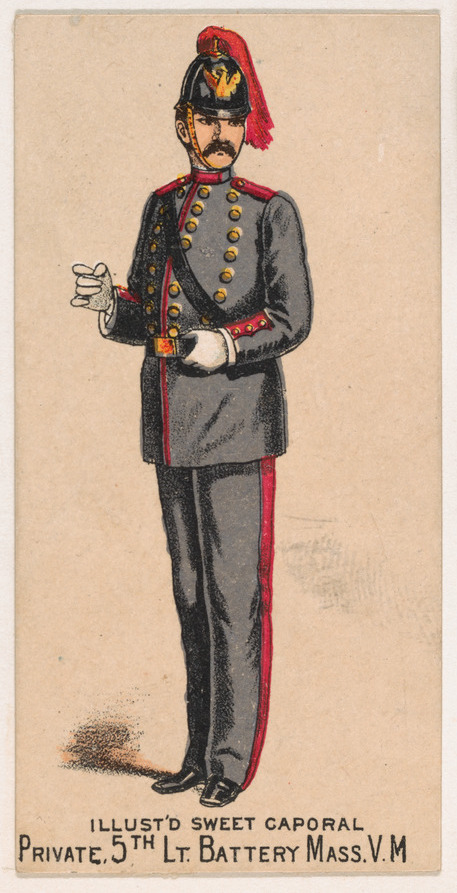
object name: print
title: Private, 5th Light Battery, Massachusetts, V.M., from the Military Series (N224) issued by Kinney Tobacco Company to promote Sweet Caporal Cigarettes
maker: kinney brothers tobacco company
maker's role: publisher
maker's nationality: american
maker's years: 1869-2011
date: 1888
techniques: color lithograph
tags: military,men